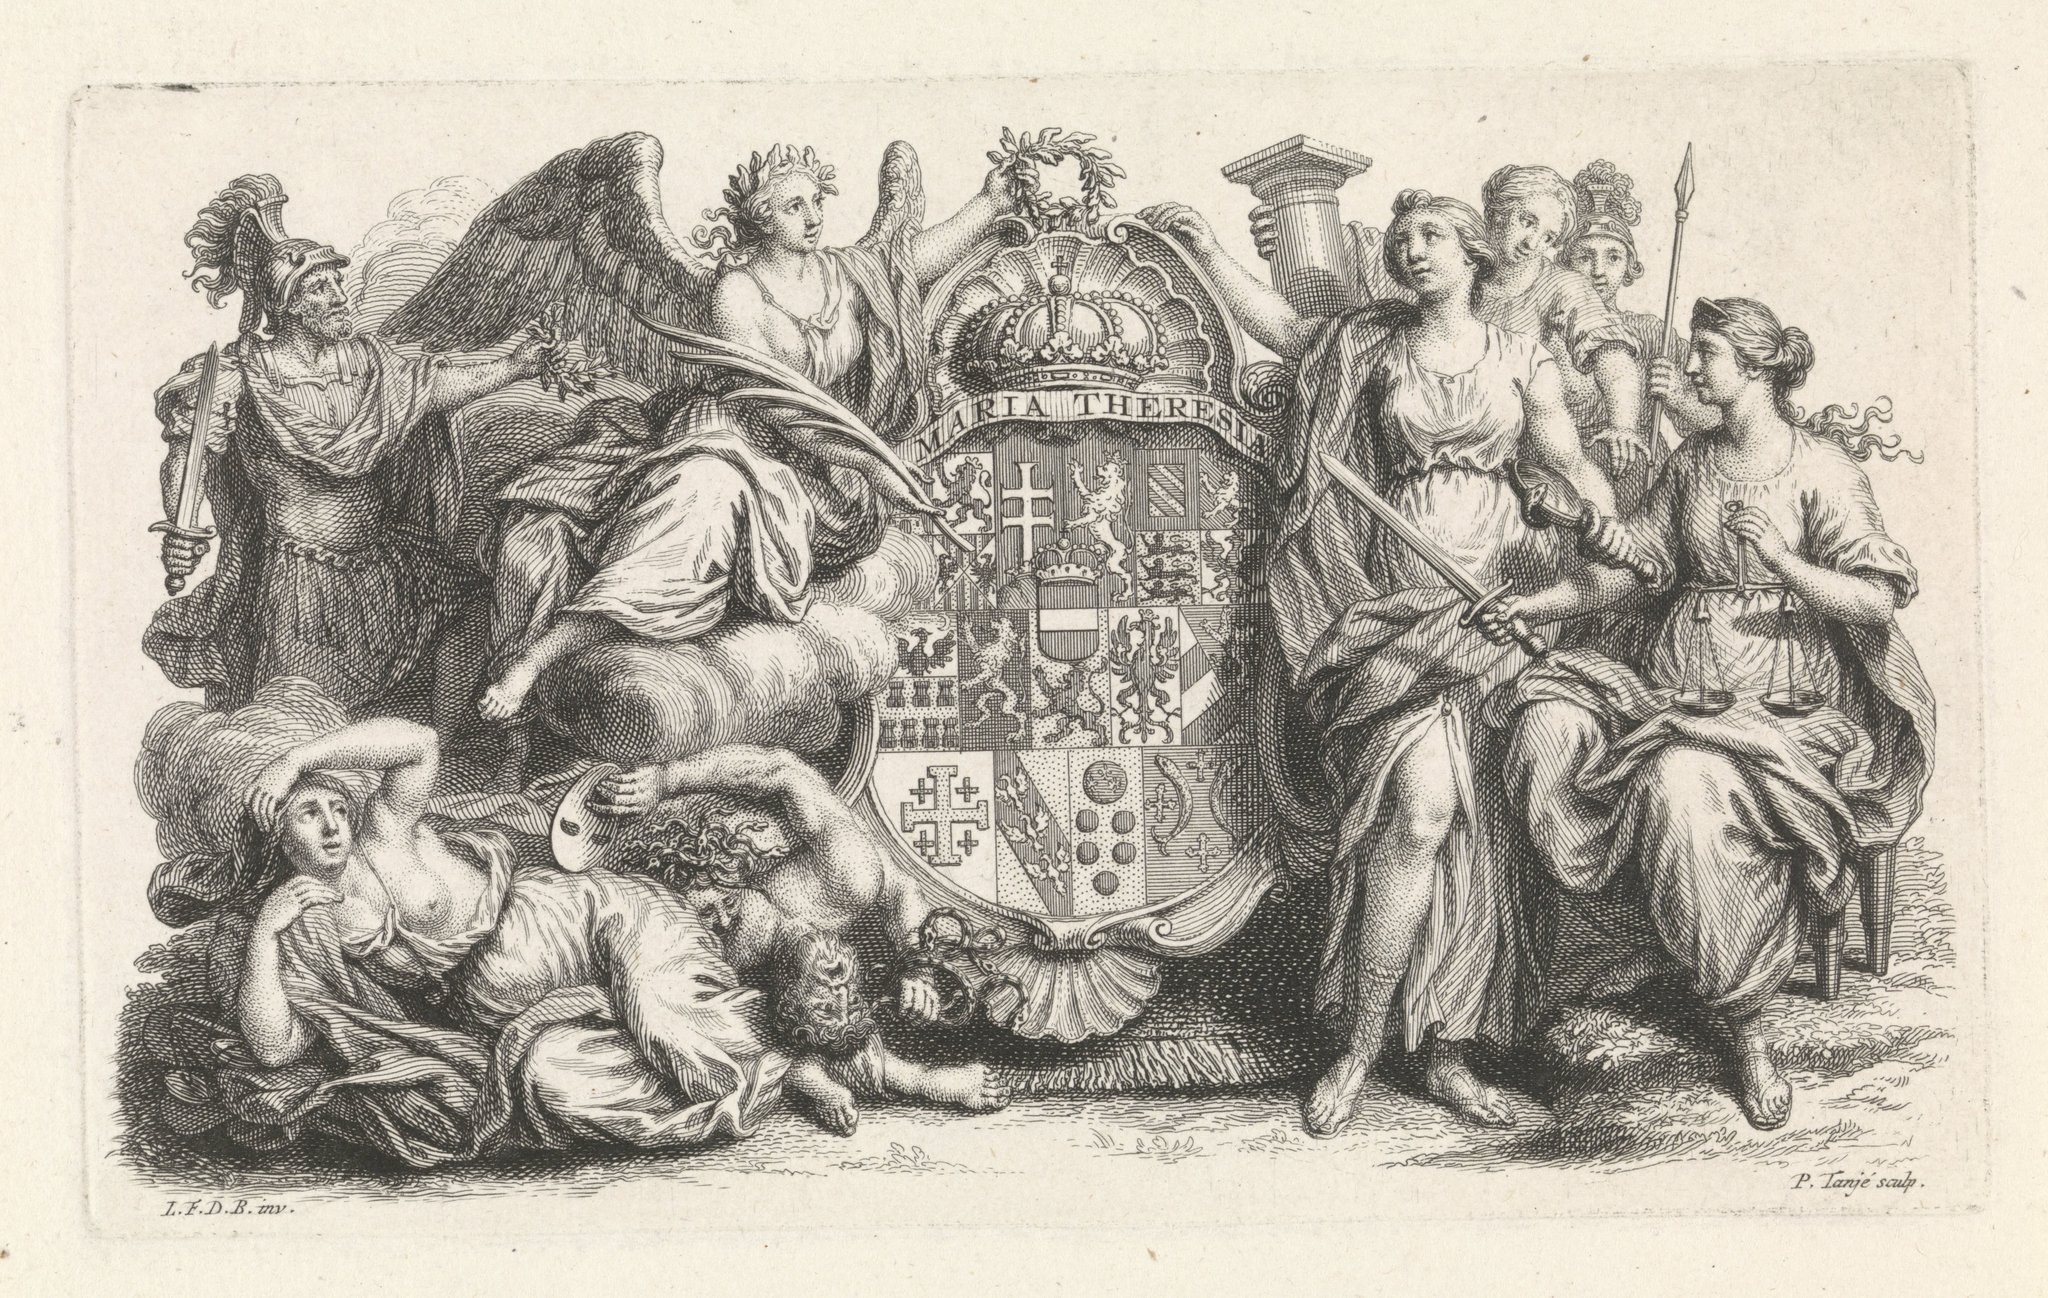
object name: print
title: Wapen van Rooms-Duits keizerin Maria Theresia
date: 1716-1761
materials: paper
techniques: engraving, etching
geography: amsterdam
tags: vienna, maria theresia (rooms-duits keizerin), fortitude, 'fortitudo' ~ one of the four cardinal virtues, justice, 'justitia'; 'giustitia divina' (ripa) ~ one of the four cardinal virtues, prudence, 'prudentia'; 'prudenza' (ripa) ~ one of the four cardinal virtues, (story of) mars (ares), fame; 'fama', 'fama buona', 'fama chiara' (ripa)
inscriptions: collector's mark: Lugt 240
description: Het wapenschild van Rooms-Duits keizerin Maria Theresia wordt door Faam met een lauwerkrans gekroond. Zij staat op de Afgunst en de Nijd. Links van Faam staat Mars. Rechts staan de kardinale deugeden Voorzichtigheid, Kracht en Rechtvaardigheid.